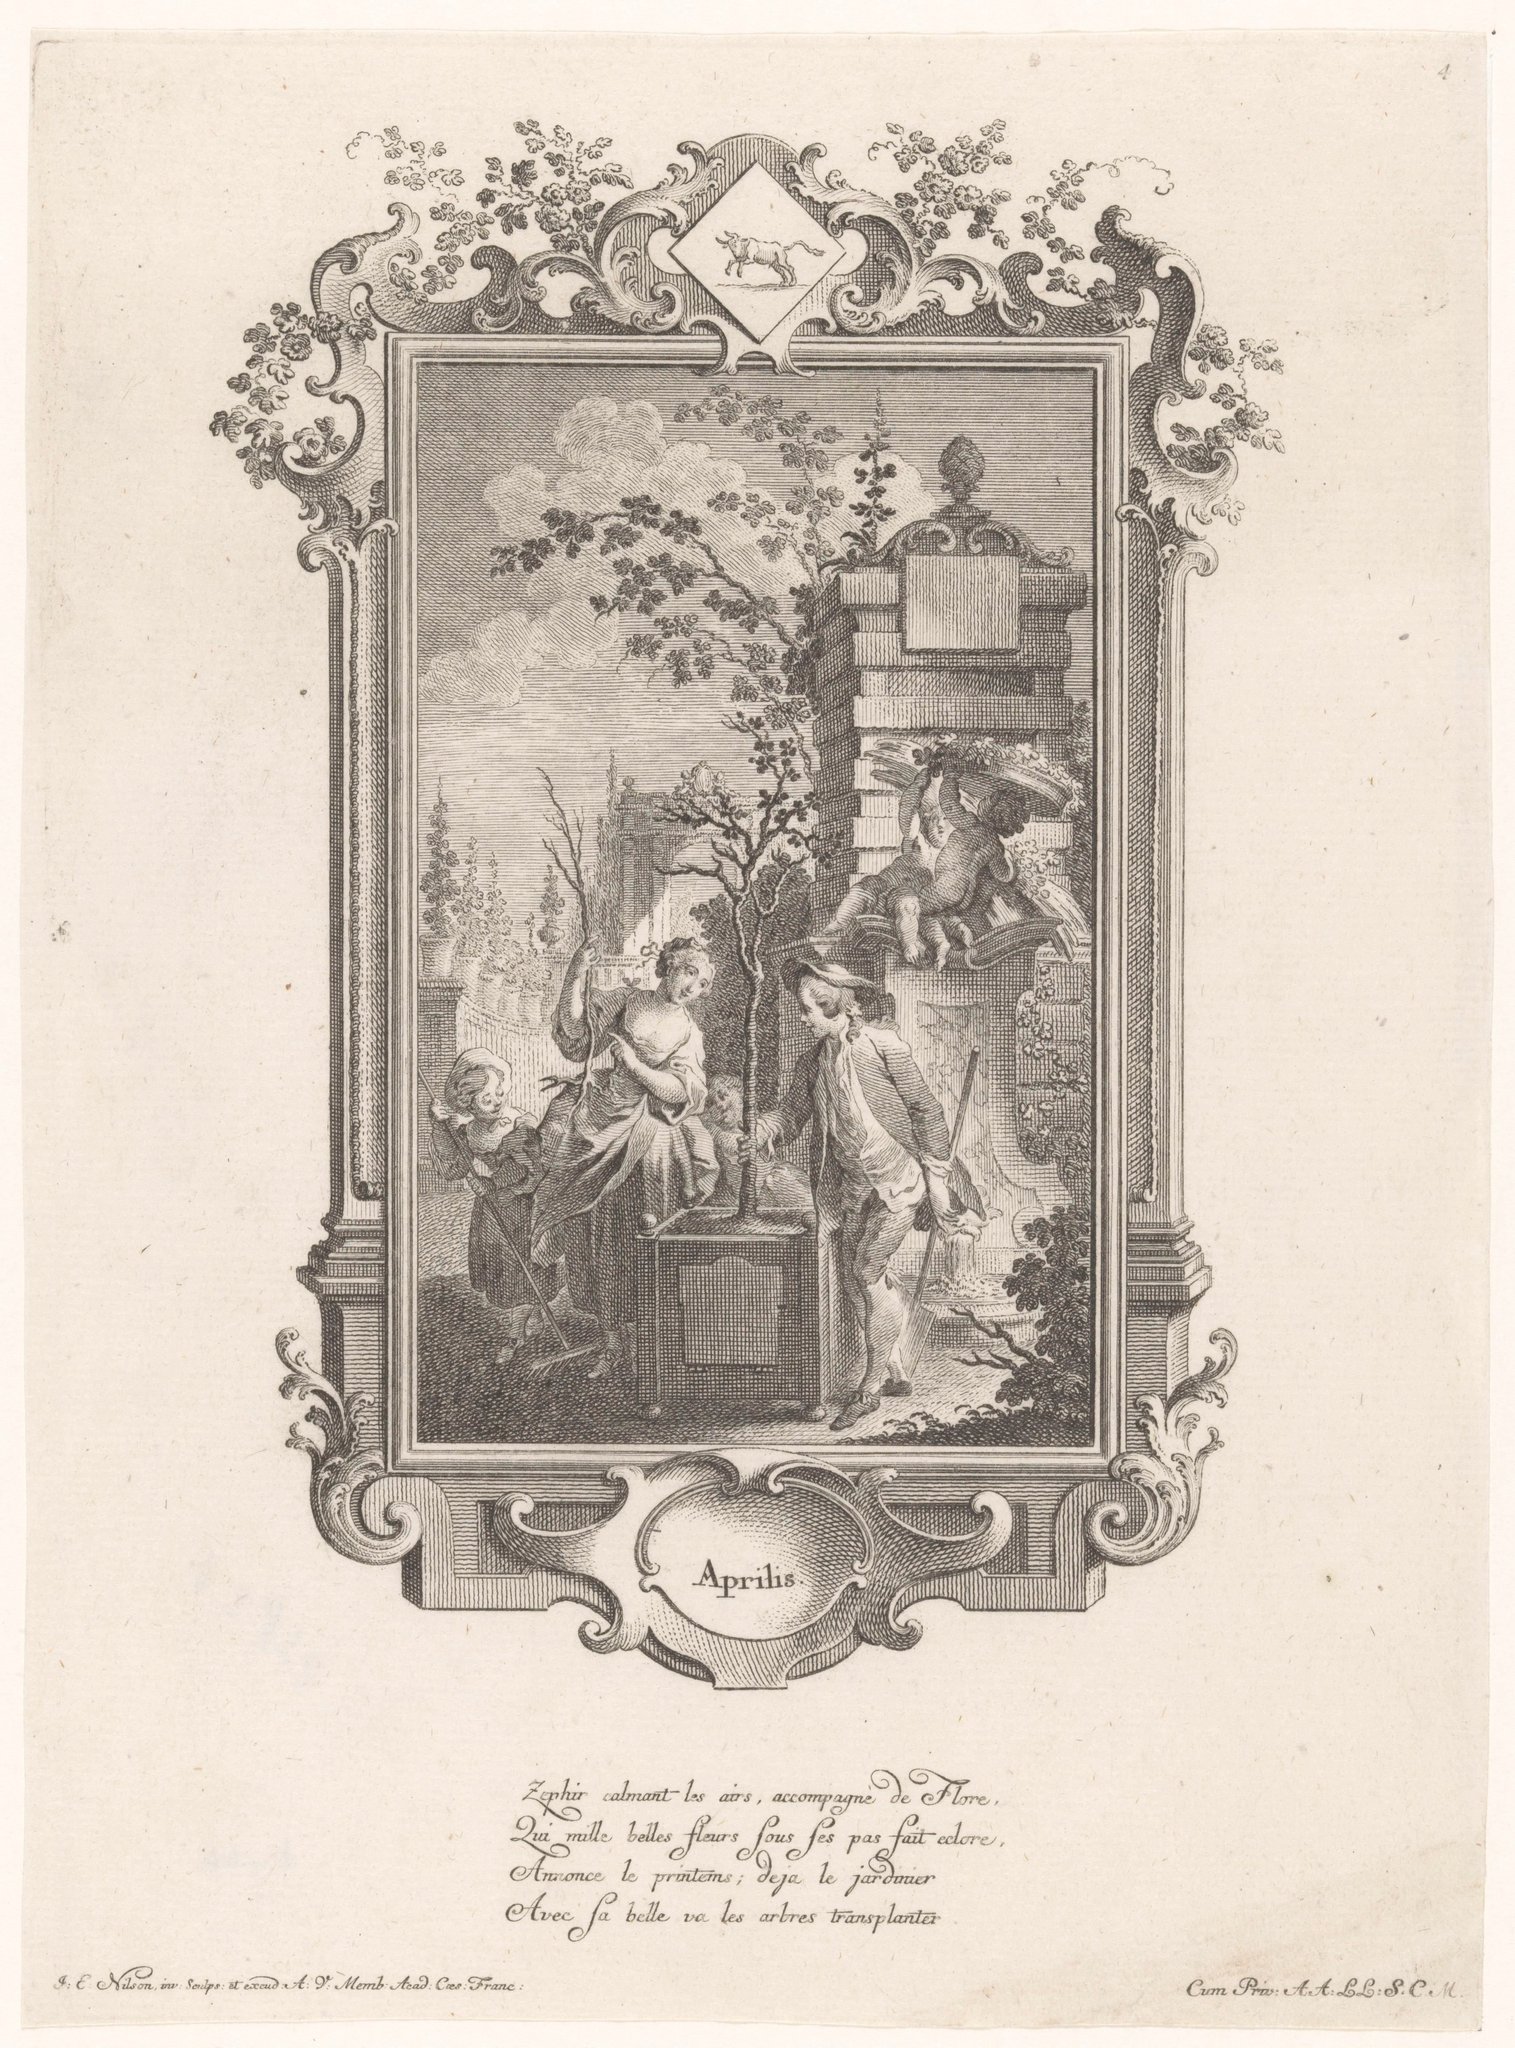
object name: print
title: De twaalf maanden van het jaar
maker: johann esaias nilson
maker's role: draughtsman, print maker, publisher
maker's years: 1721-1788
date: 1766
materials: paper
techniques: engraving, etching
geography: augsburg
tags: april and its 'labours', transplanting, setting out plants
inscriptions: collector's mark: Lugt 2228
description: In een rocaille omlijsting een voorstelling van een man en een vrouw in een tuin. Samen met twee kinderen planten zij jonge bomen. In de ondermarge een vierregelige Franse tekst.